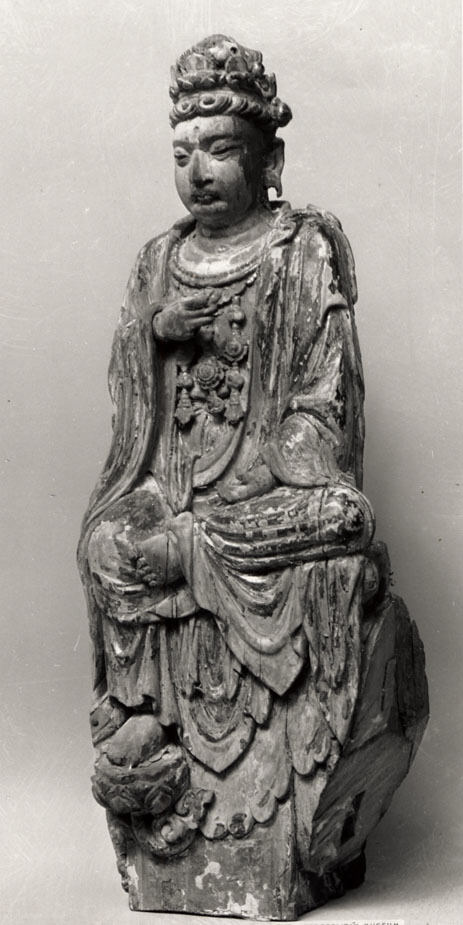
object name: statuette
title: Statuette of Bodhisattva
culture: chinese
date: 1368-1644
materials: gilt, wood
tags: bodhisattvas